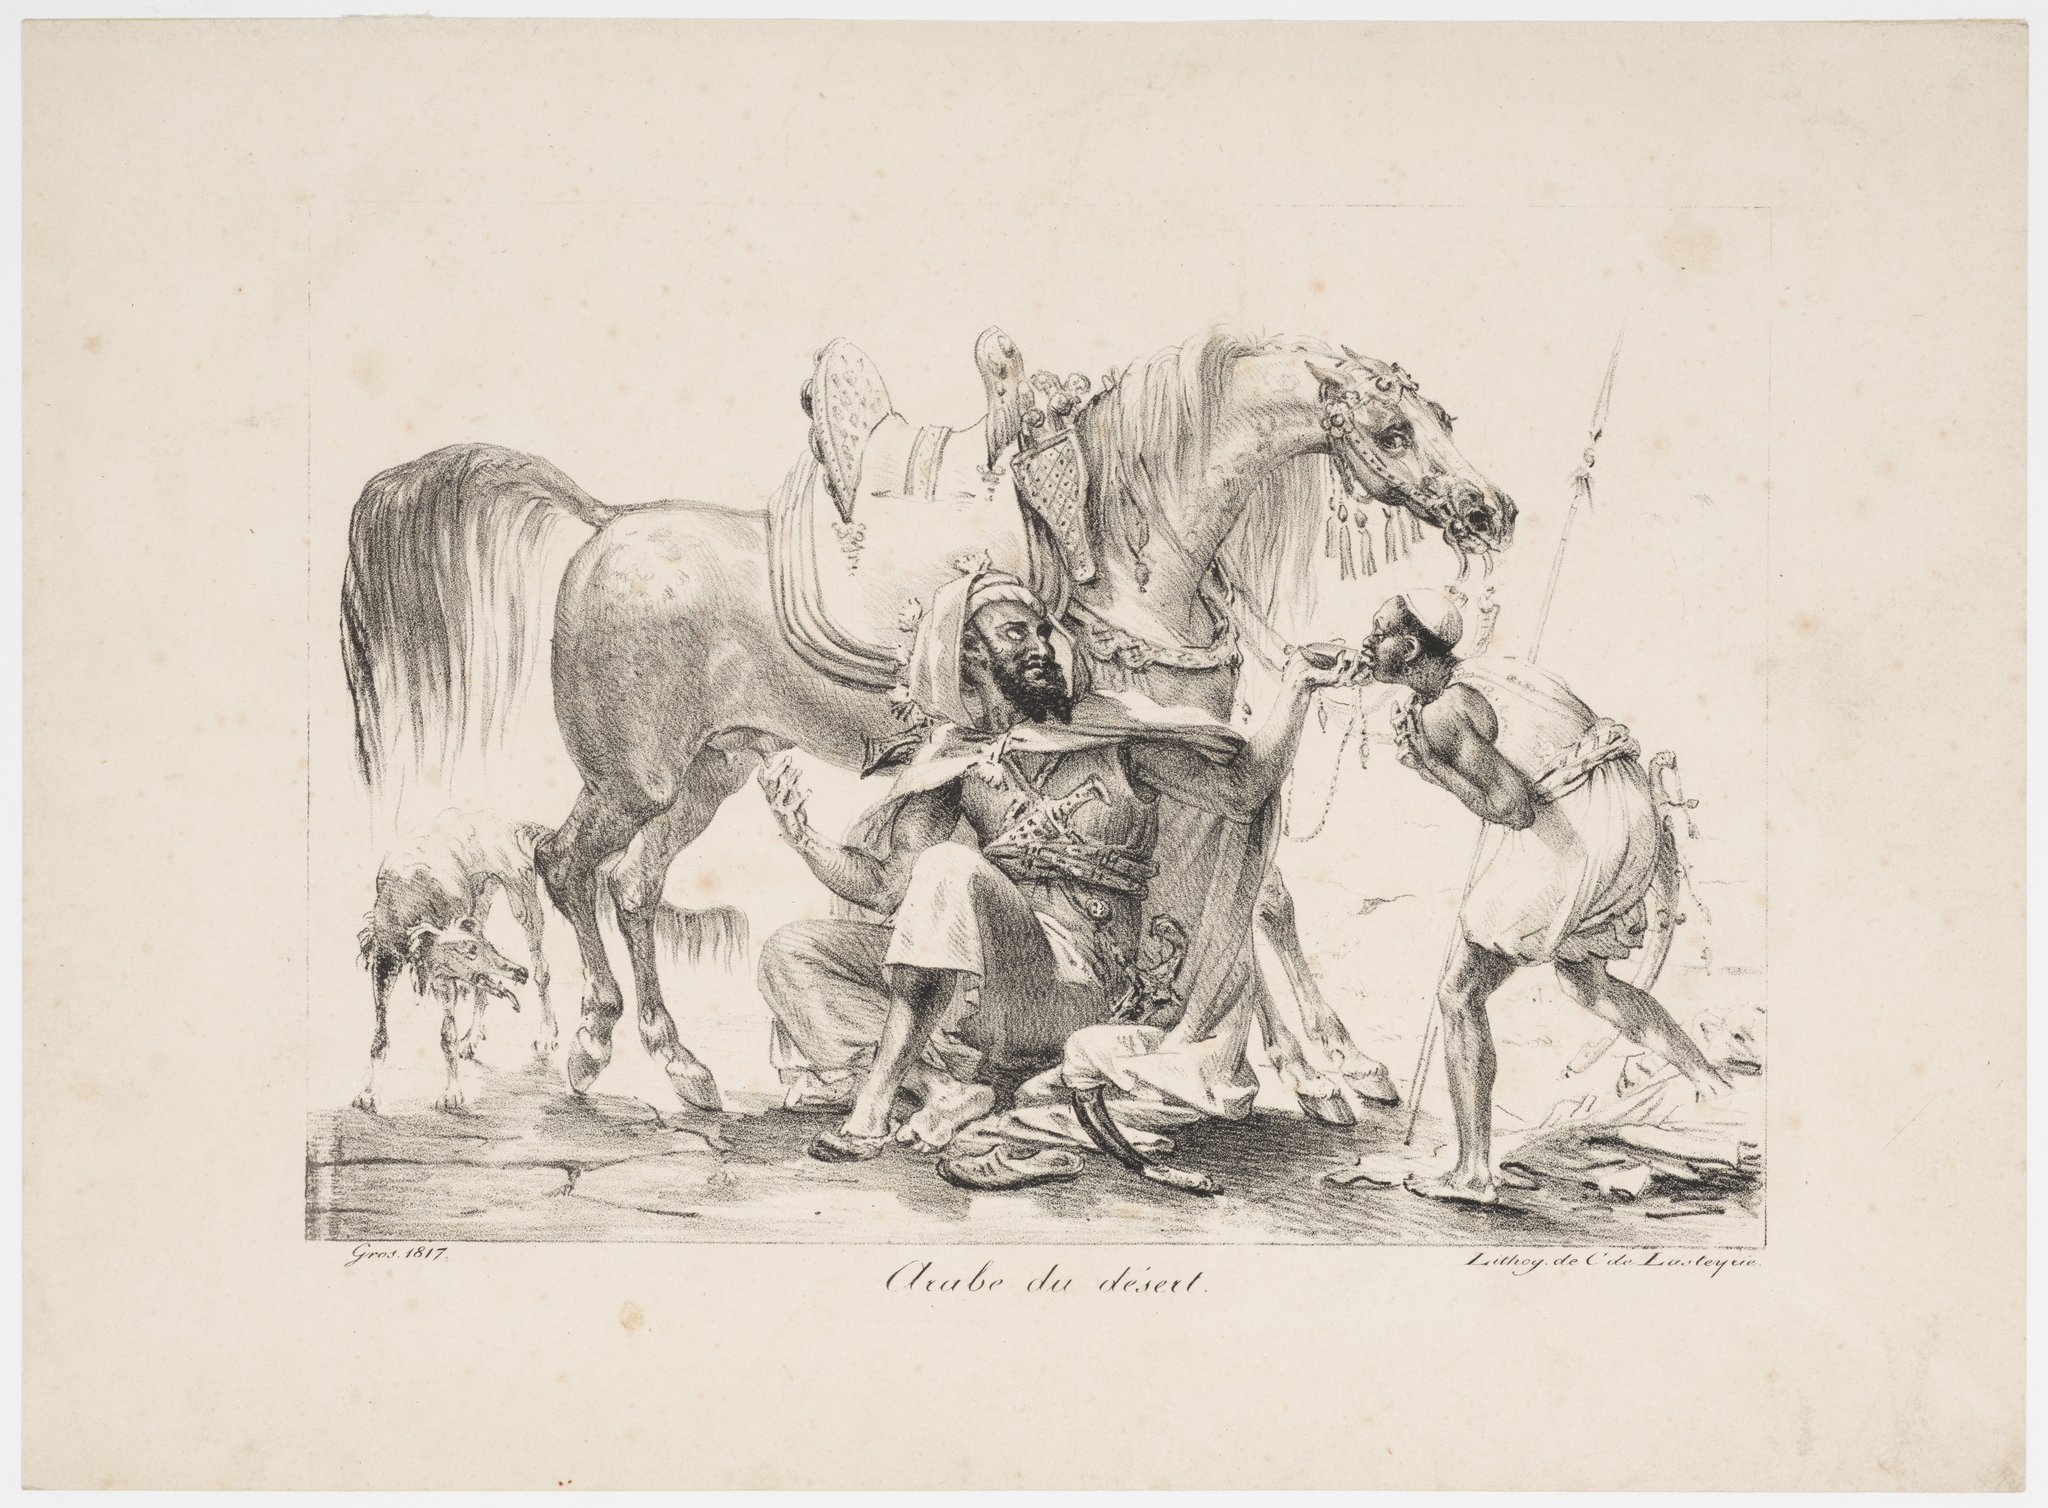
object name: print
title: Arabe du Desert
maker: baron antoine jean gros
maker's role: artist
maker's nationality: french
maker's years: 1771-1835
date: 1817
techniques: lithograph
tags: men,horses